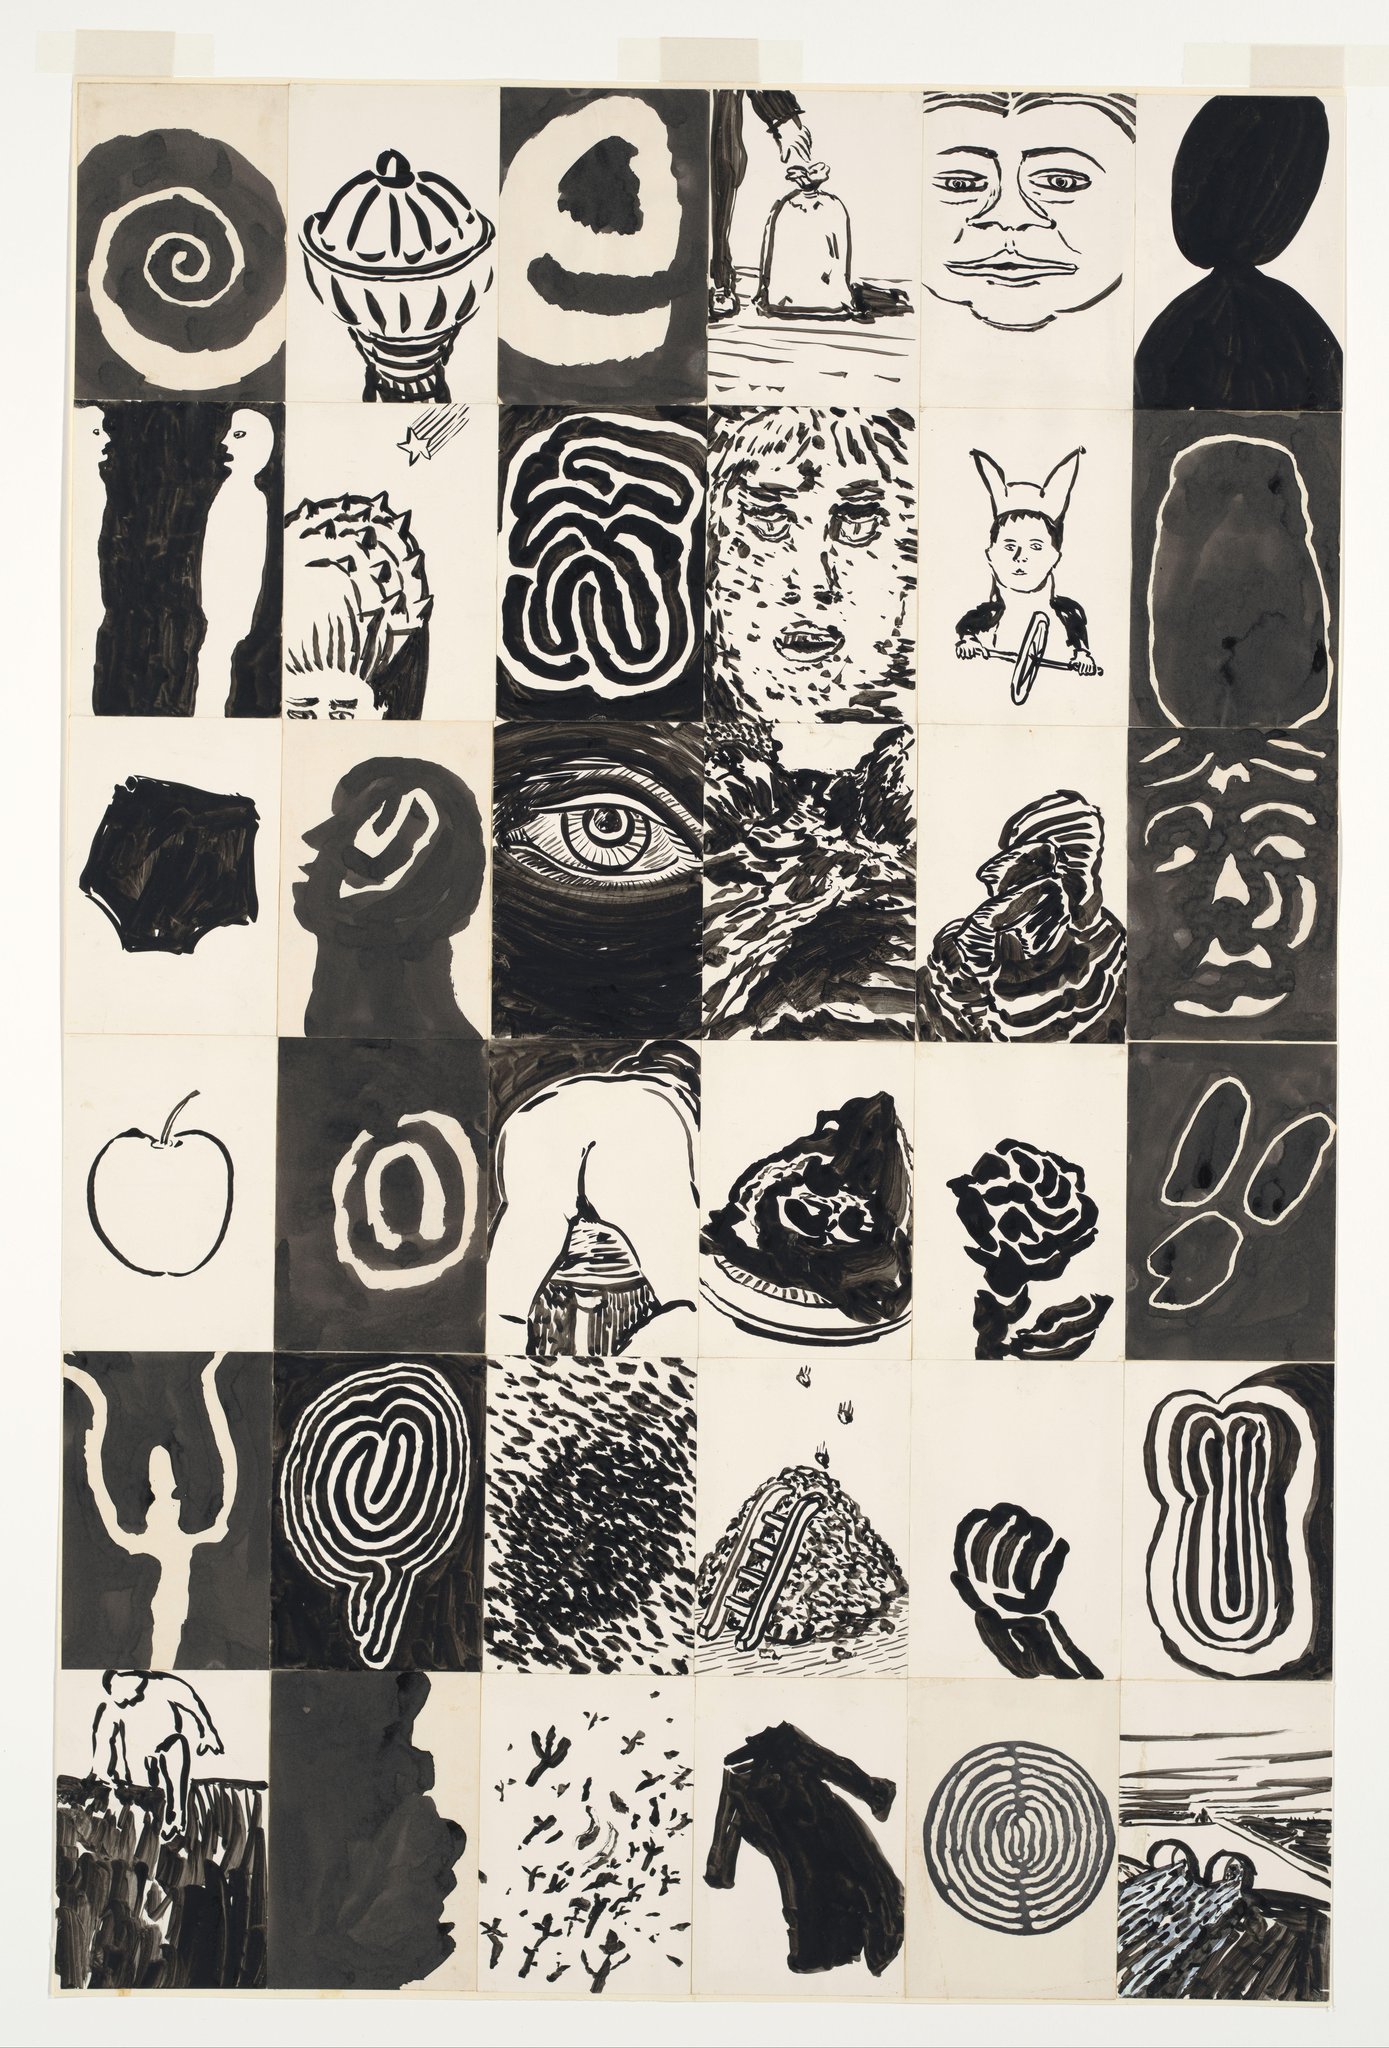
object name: drawing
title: The waterfall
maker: pieter holstein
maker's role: draughtsman, painter, print maker, sculptor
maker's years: 1934-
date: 1954-2008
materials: ink, paper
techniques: brush, collage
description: De huidige titel is door het Rijksmuseum overgenomen van het Instituut Collectie Nederland.